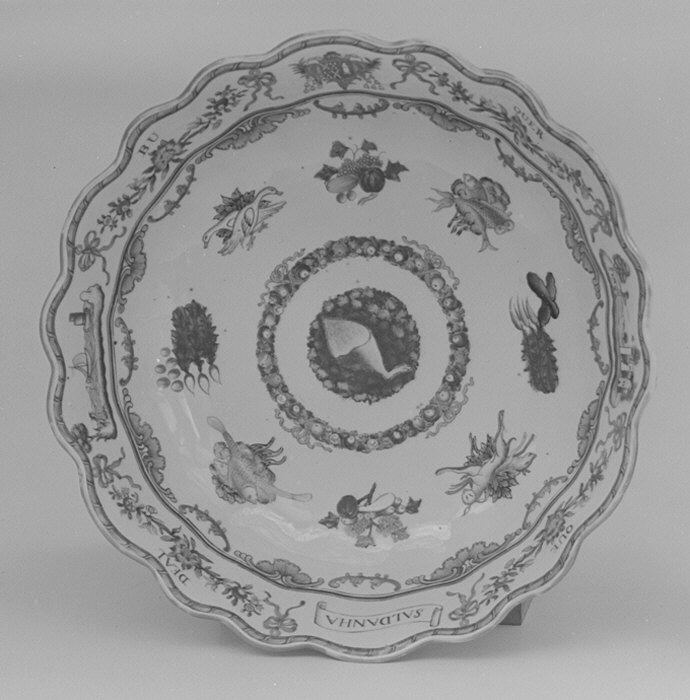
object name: bowl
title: Bowl (part of a service)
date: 1765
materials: hard paste porcelain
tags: animals,birds,grapes,fish